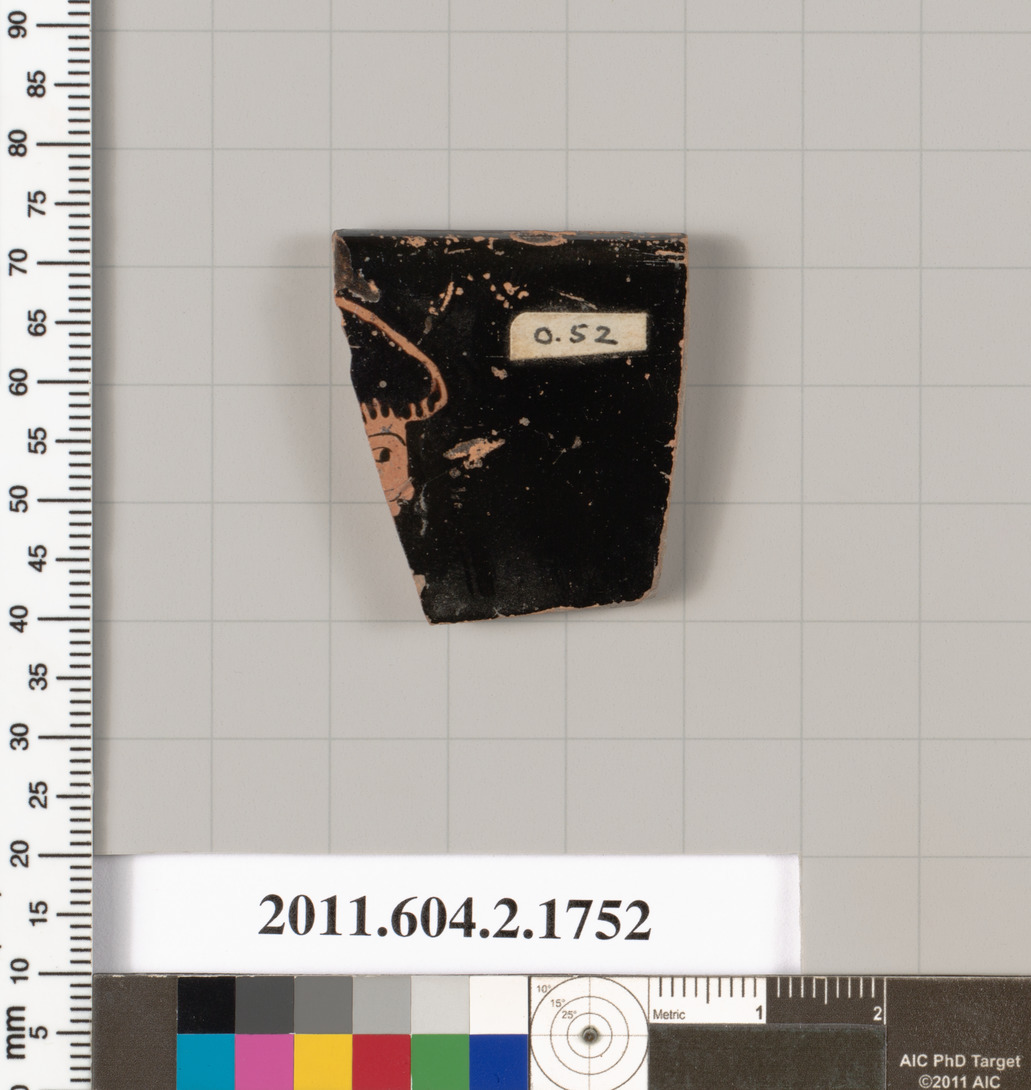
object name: skyphos fragment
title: Terracotta rim fragment of a skyphos (deep drinking cup)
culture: greek, attic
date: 460-440 BCE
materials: terracotta